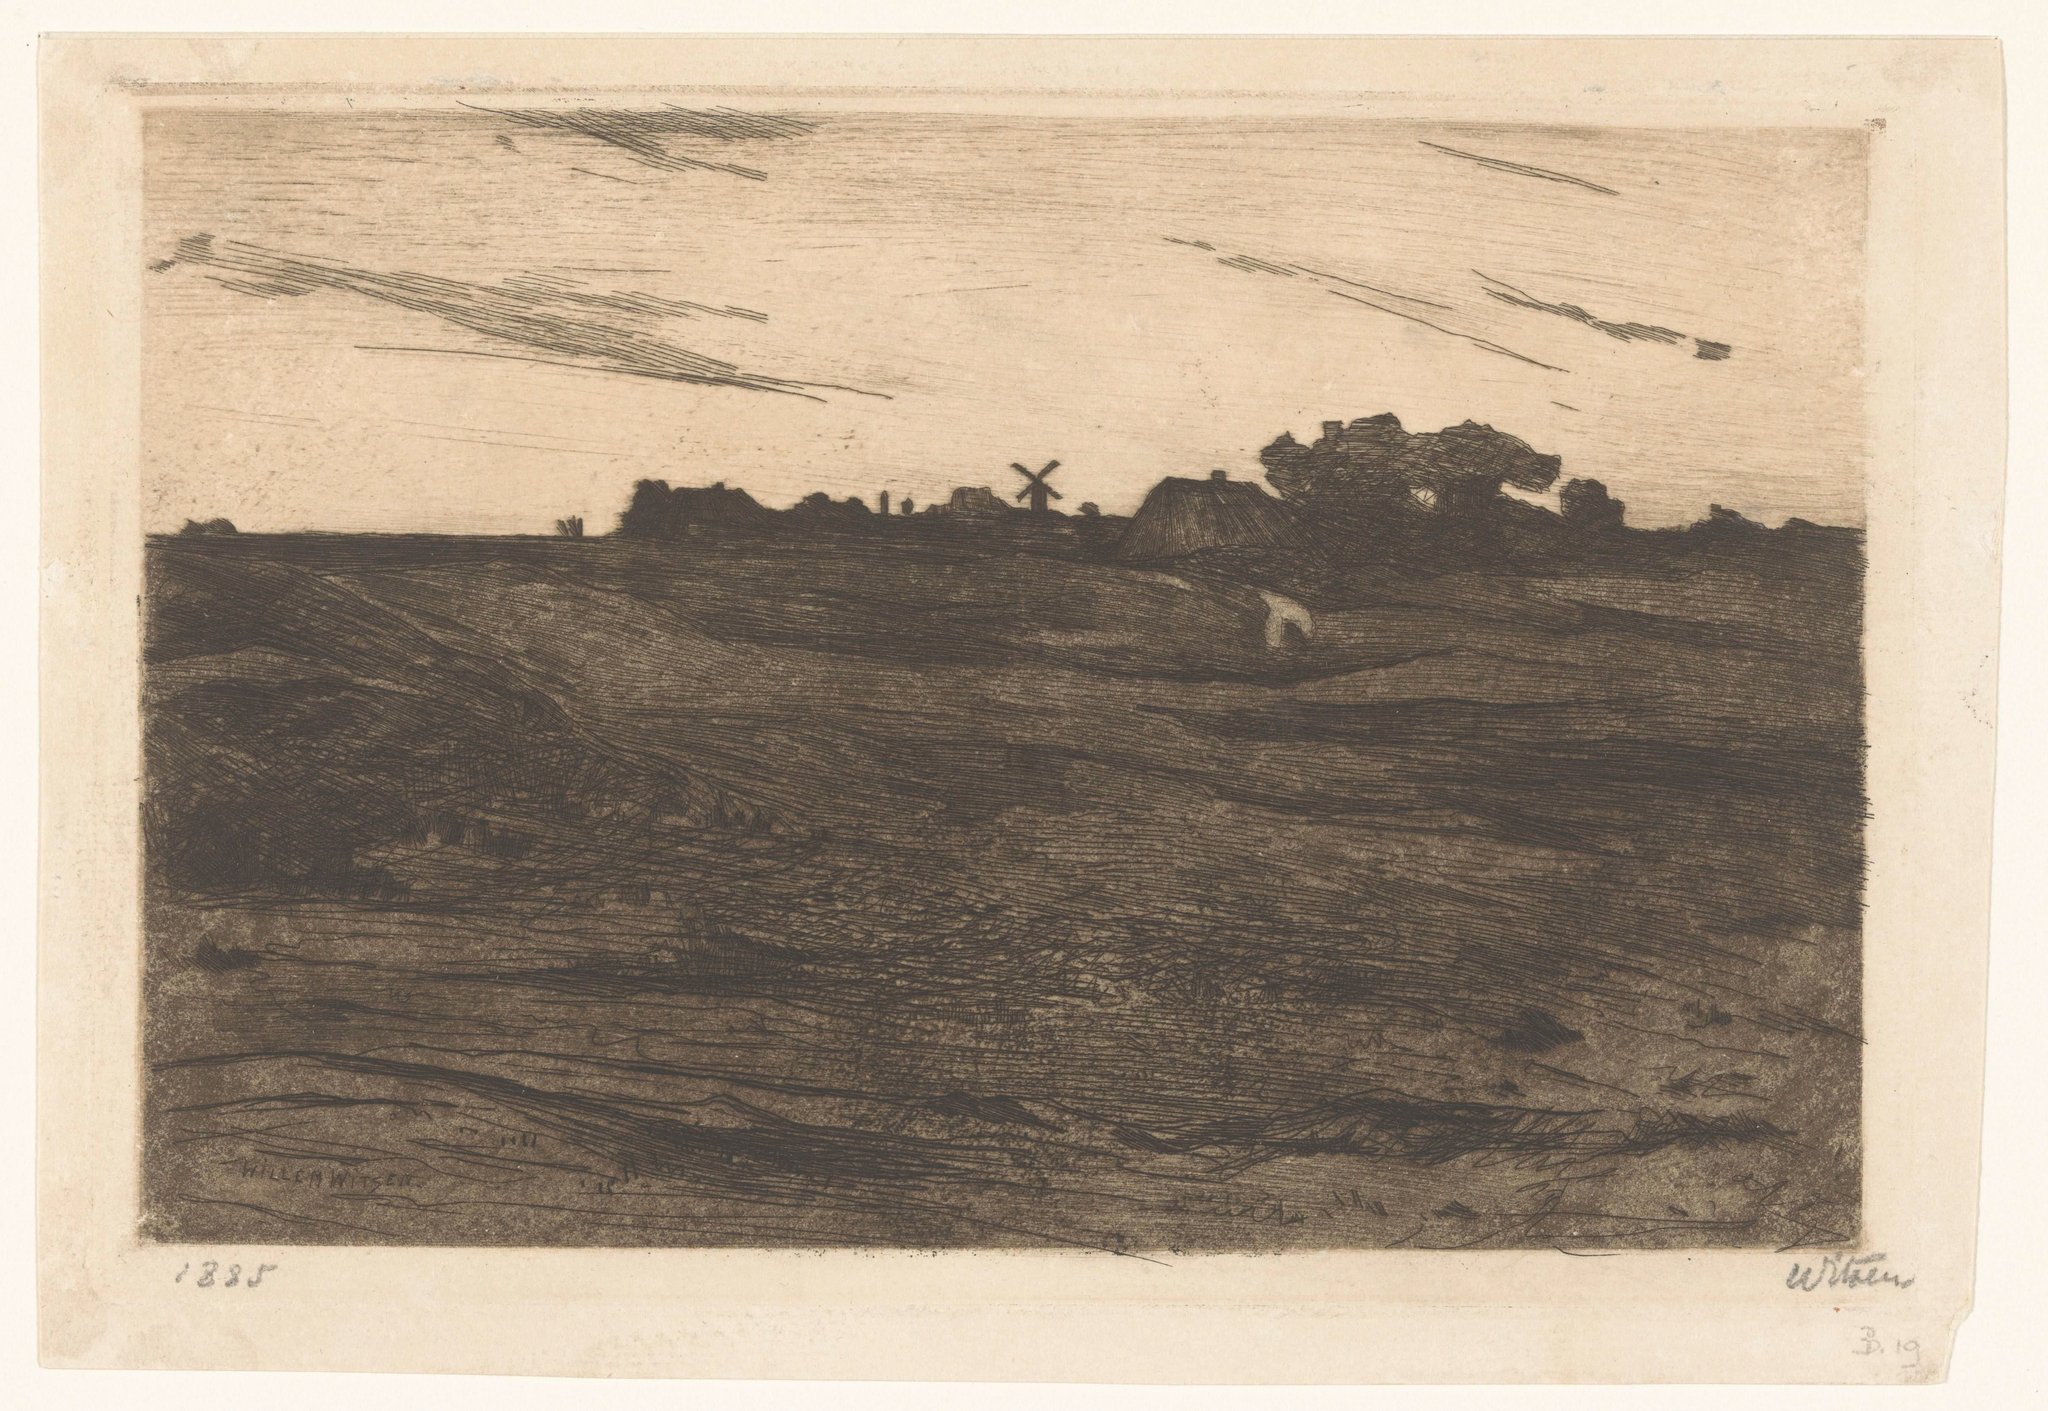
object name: print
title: Landschap met molen aan de horizon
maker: willem witsen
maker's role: draughtsman, painter, print maker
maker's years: 1860-1923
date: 1885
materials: paper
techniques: aquatint, etching, intaglio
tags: plantation, landscapes, watermill in landscape - ii - ideal landscapes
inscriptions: signature: ‘Witsen’, date: ‘1885’